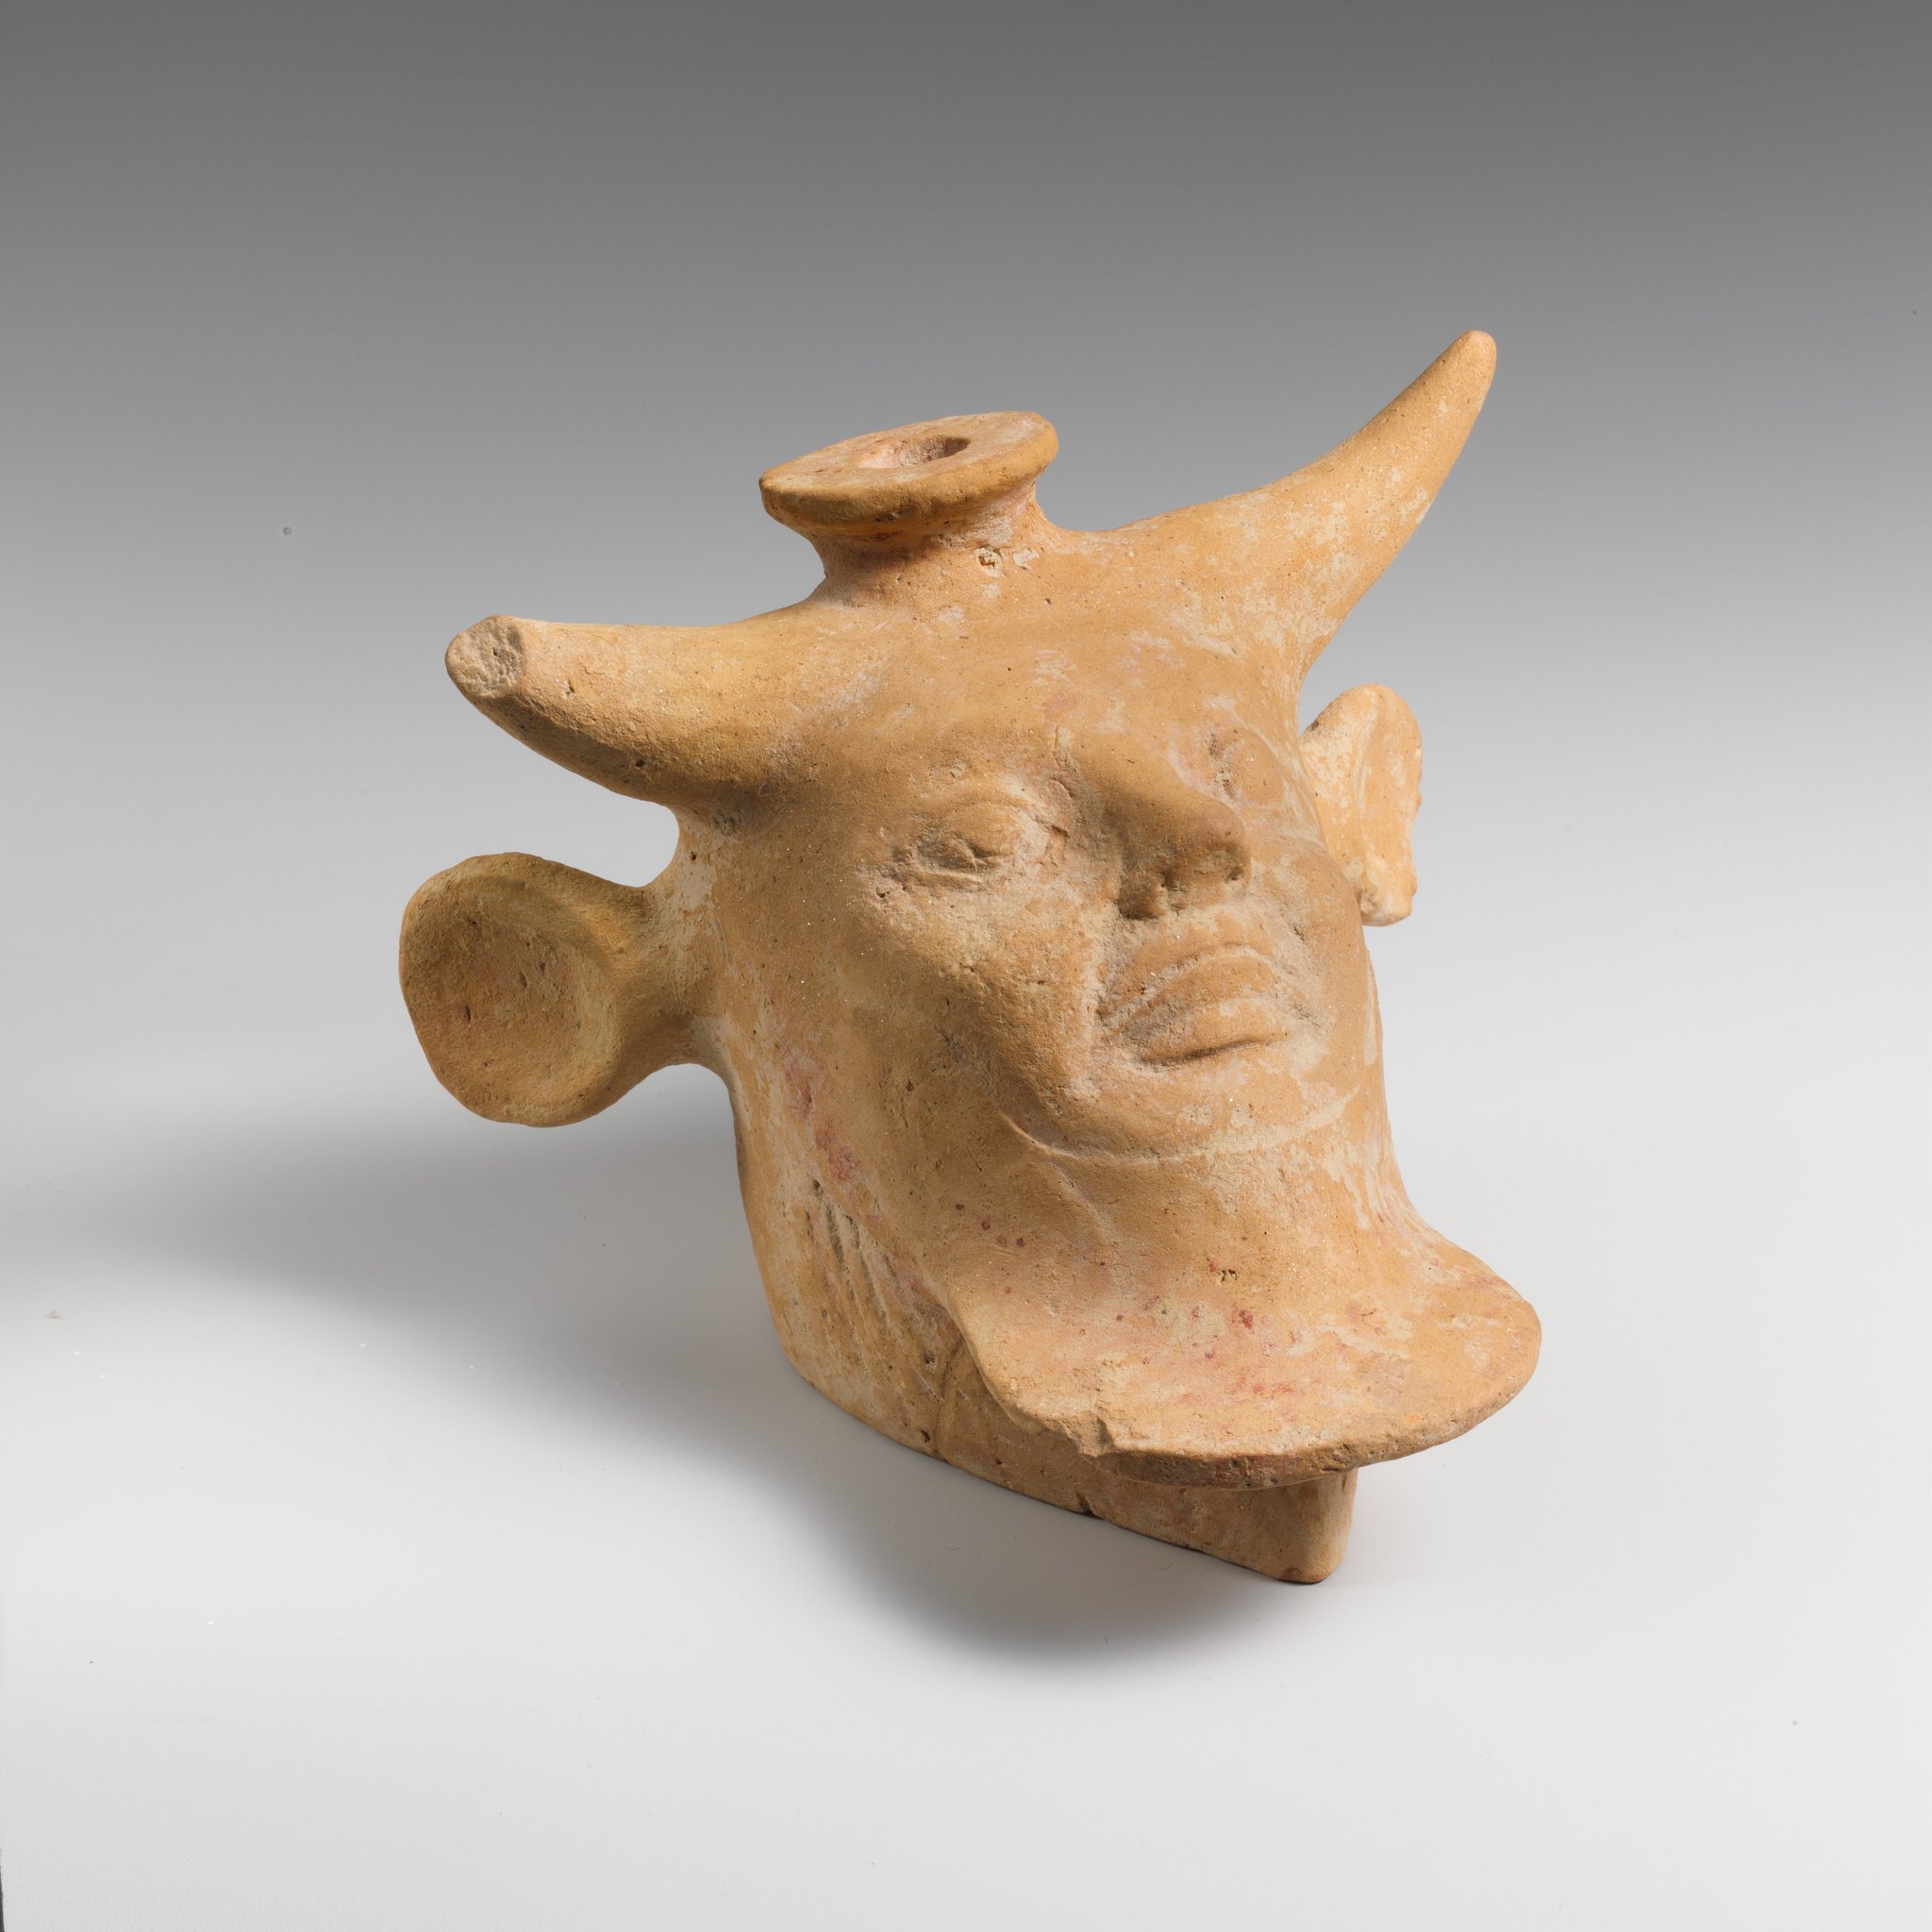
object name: vase in the form of a head of acheloos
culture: east greek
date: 550-525 BCE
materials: terracotta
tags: heads